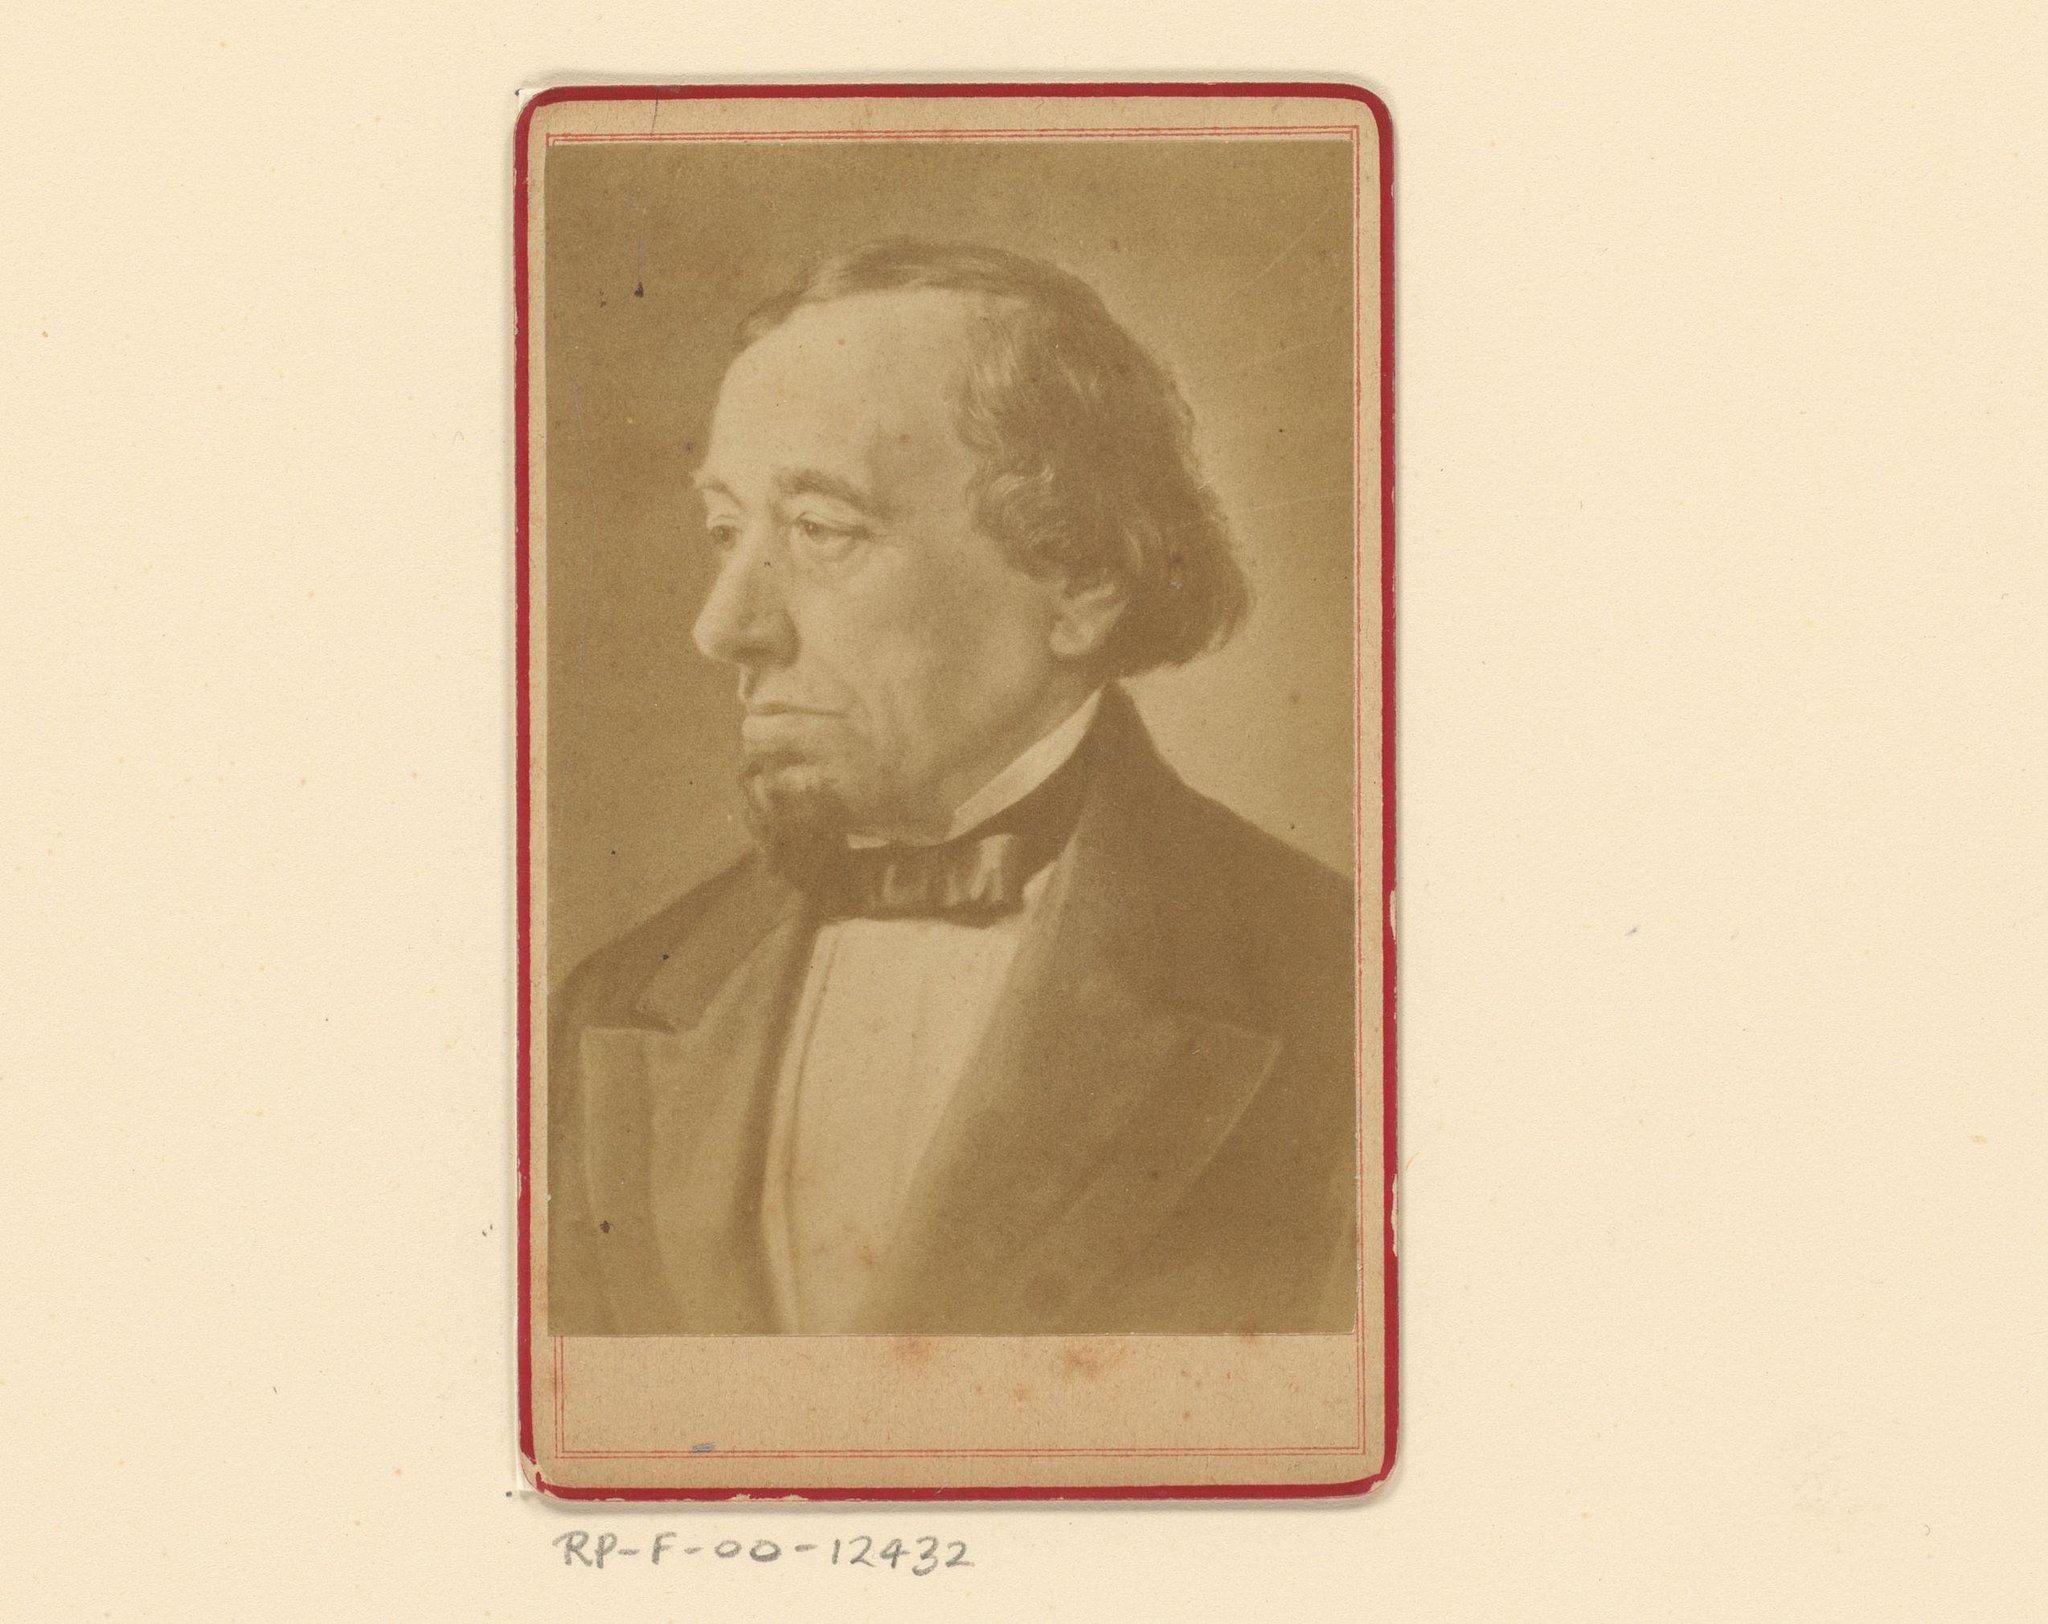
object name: carte de visite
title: Fotoreproductie van een geschilderd portret van Benjamin Disraeli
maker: Anonymous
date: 1870-1890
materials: cardboard, paper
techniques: albumen print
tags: historical persons, politician, e.g. party leader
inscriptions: inscription: ‘Disraeli/ Beaconsfield’